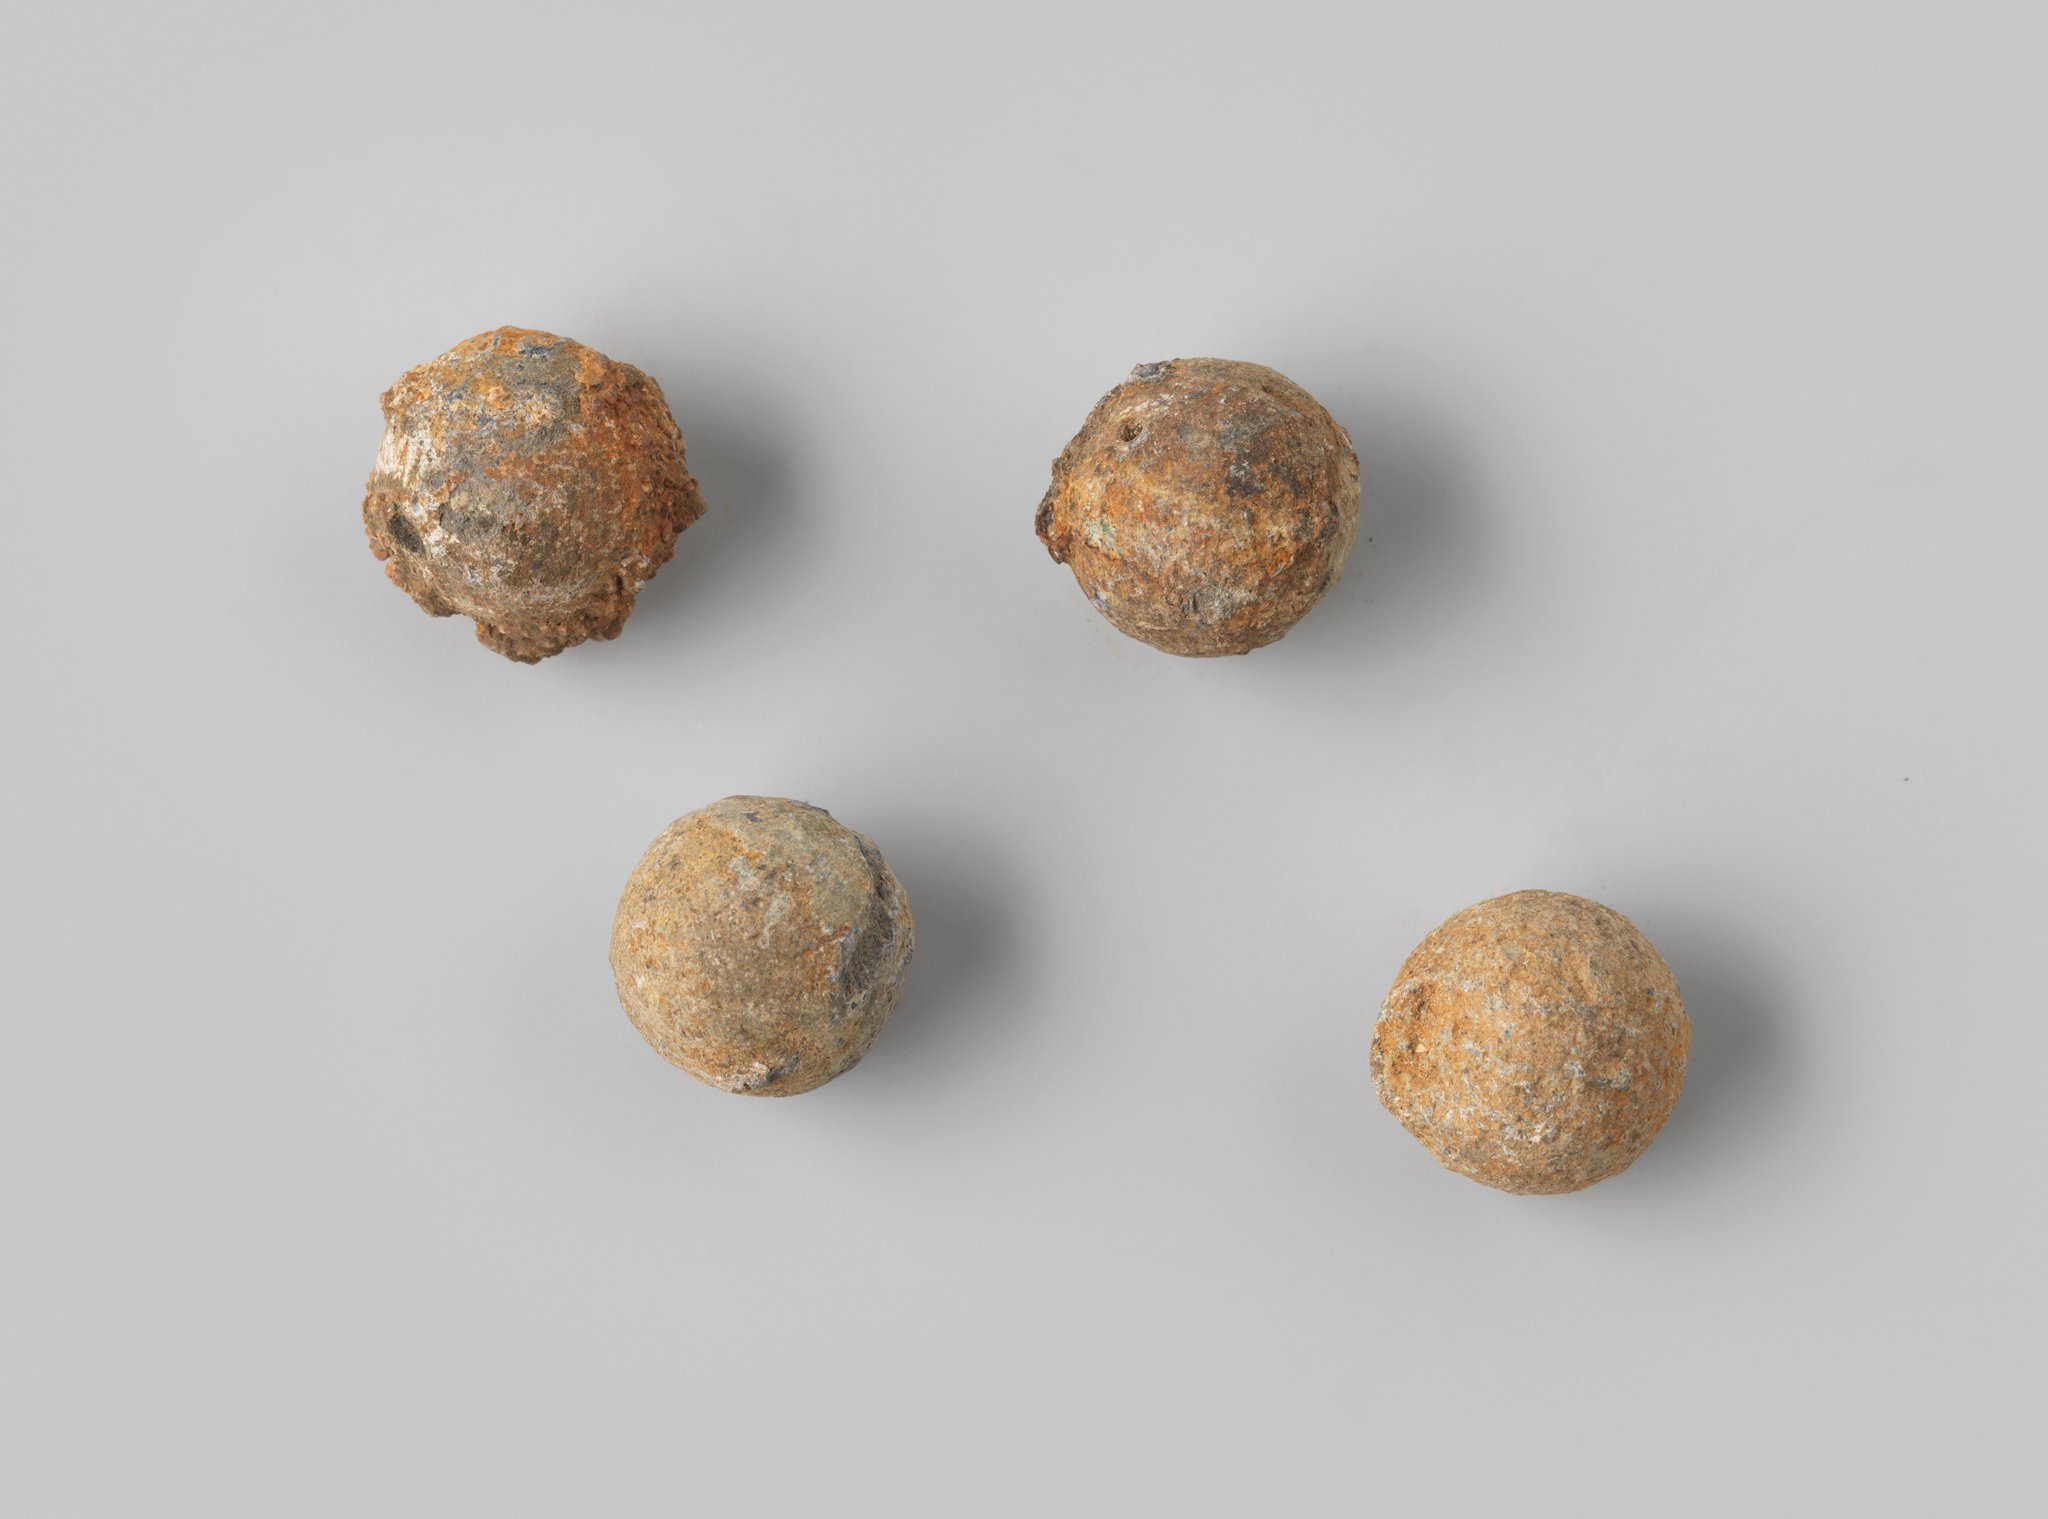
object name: musketkogel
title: Musketkogels uit het wrak van de Oost-Indiëvaarder Hollandia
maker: Anonymous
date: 1700-1743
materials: lead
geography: netherlands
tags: verenigde oostindische compagnie, hollandia (schip), annet